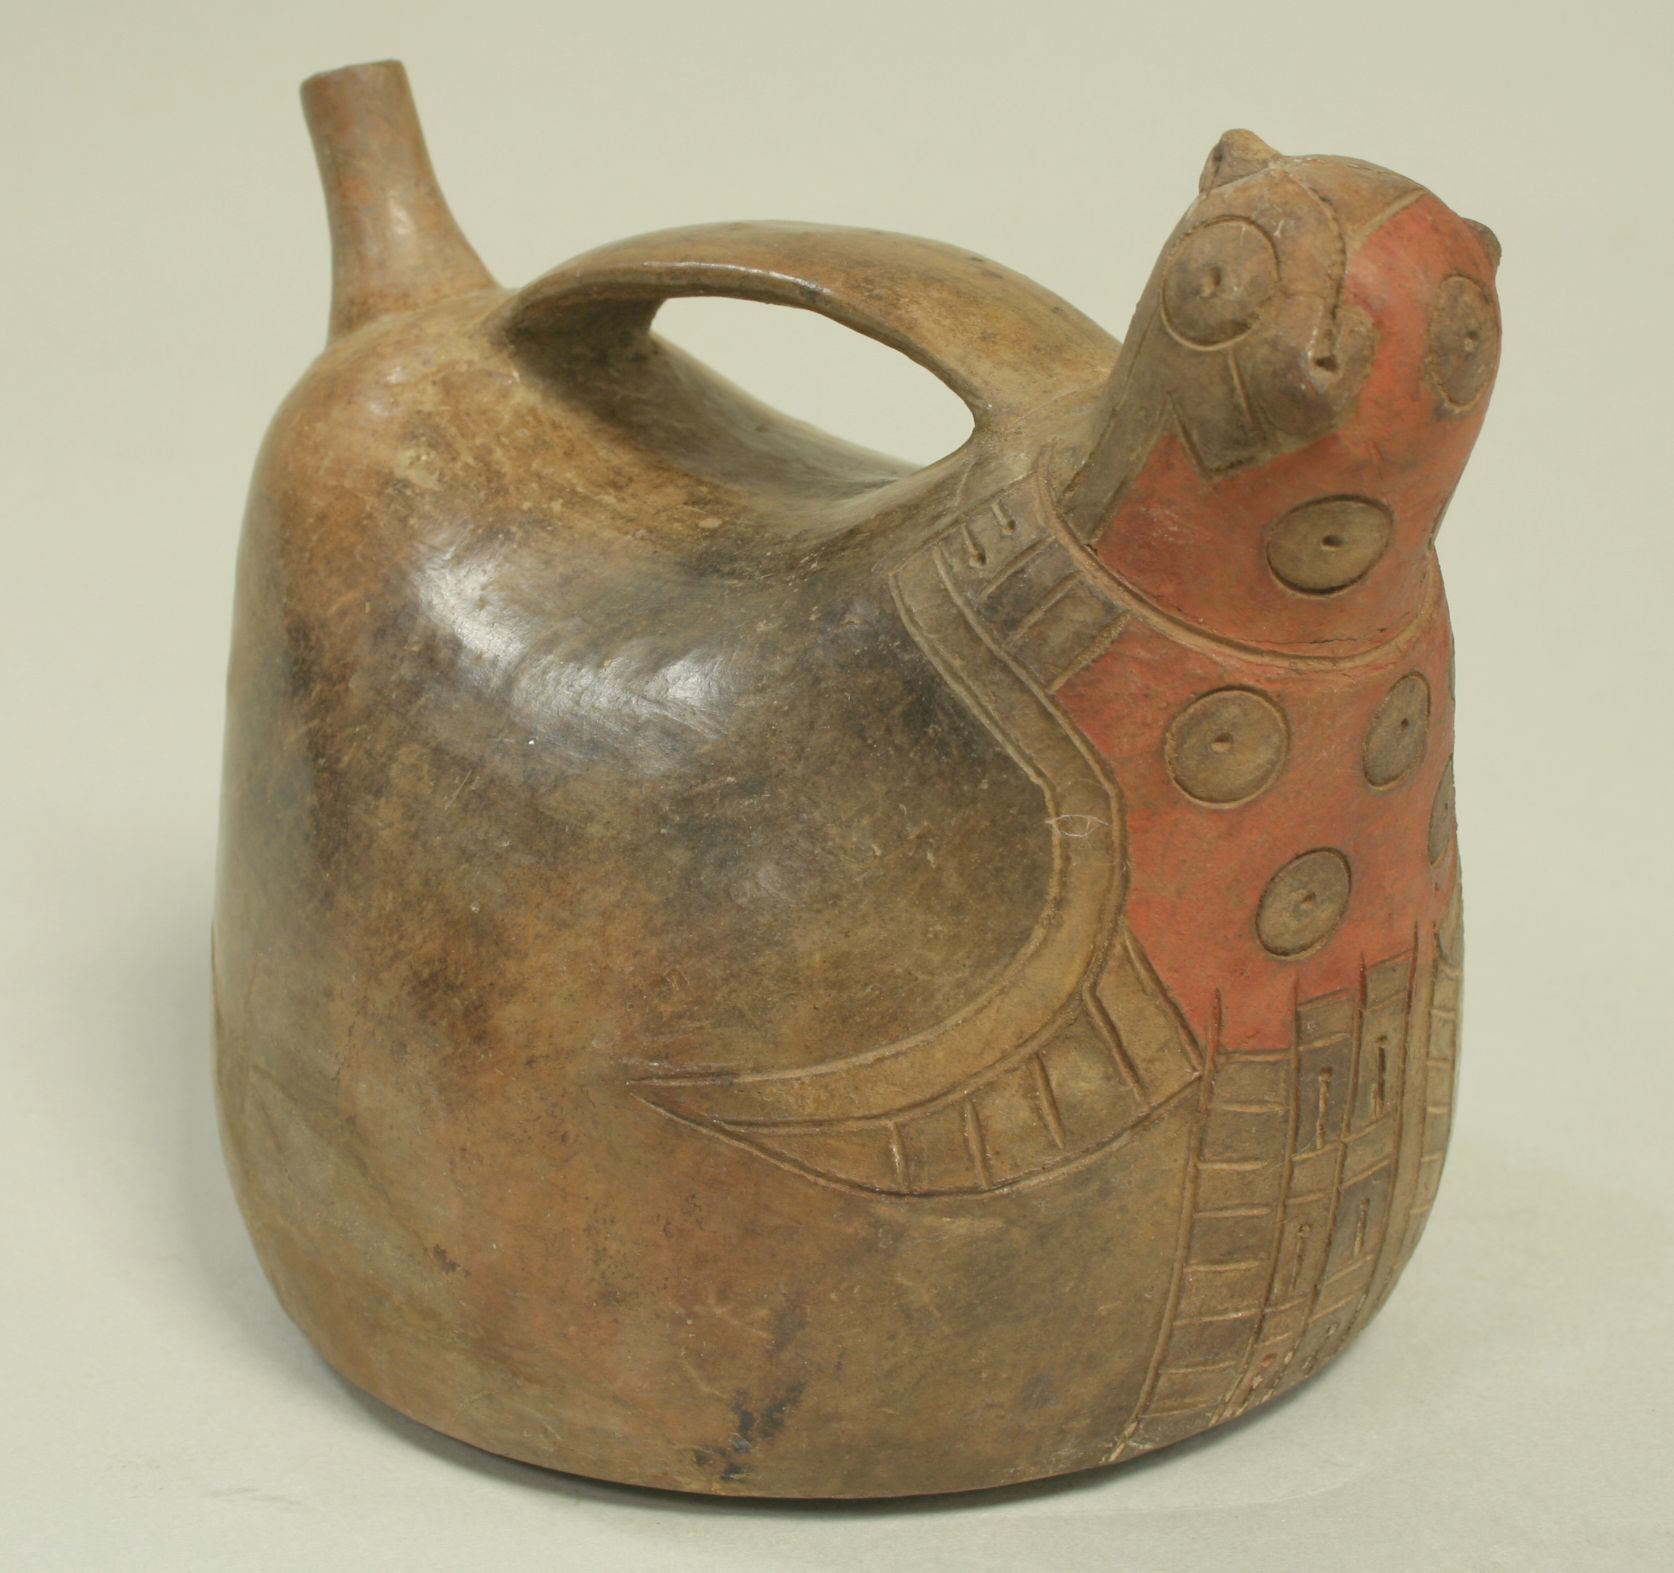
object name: bottle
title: Double Spout and Bridge Bottle with Bird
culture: paracas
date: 700-401 BCE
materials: ceramic, pigment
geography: peru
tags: birds